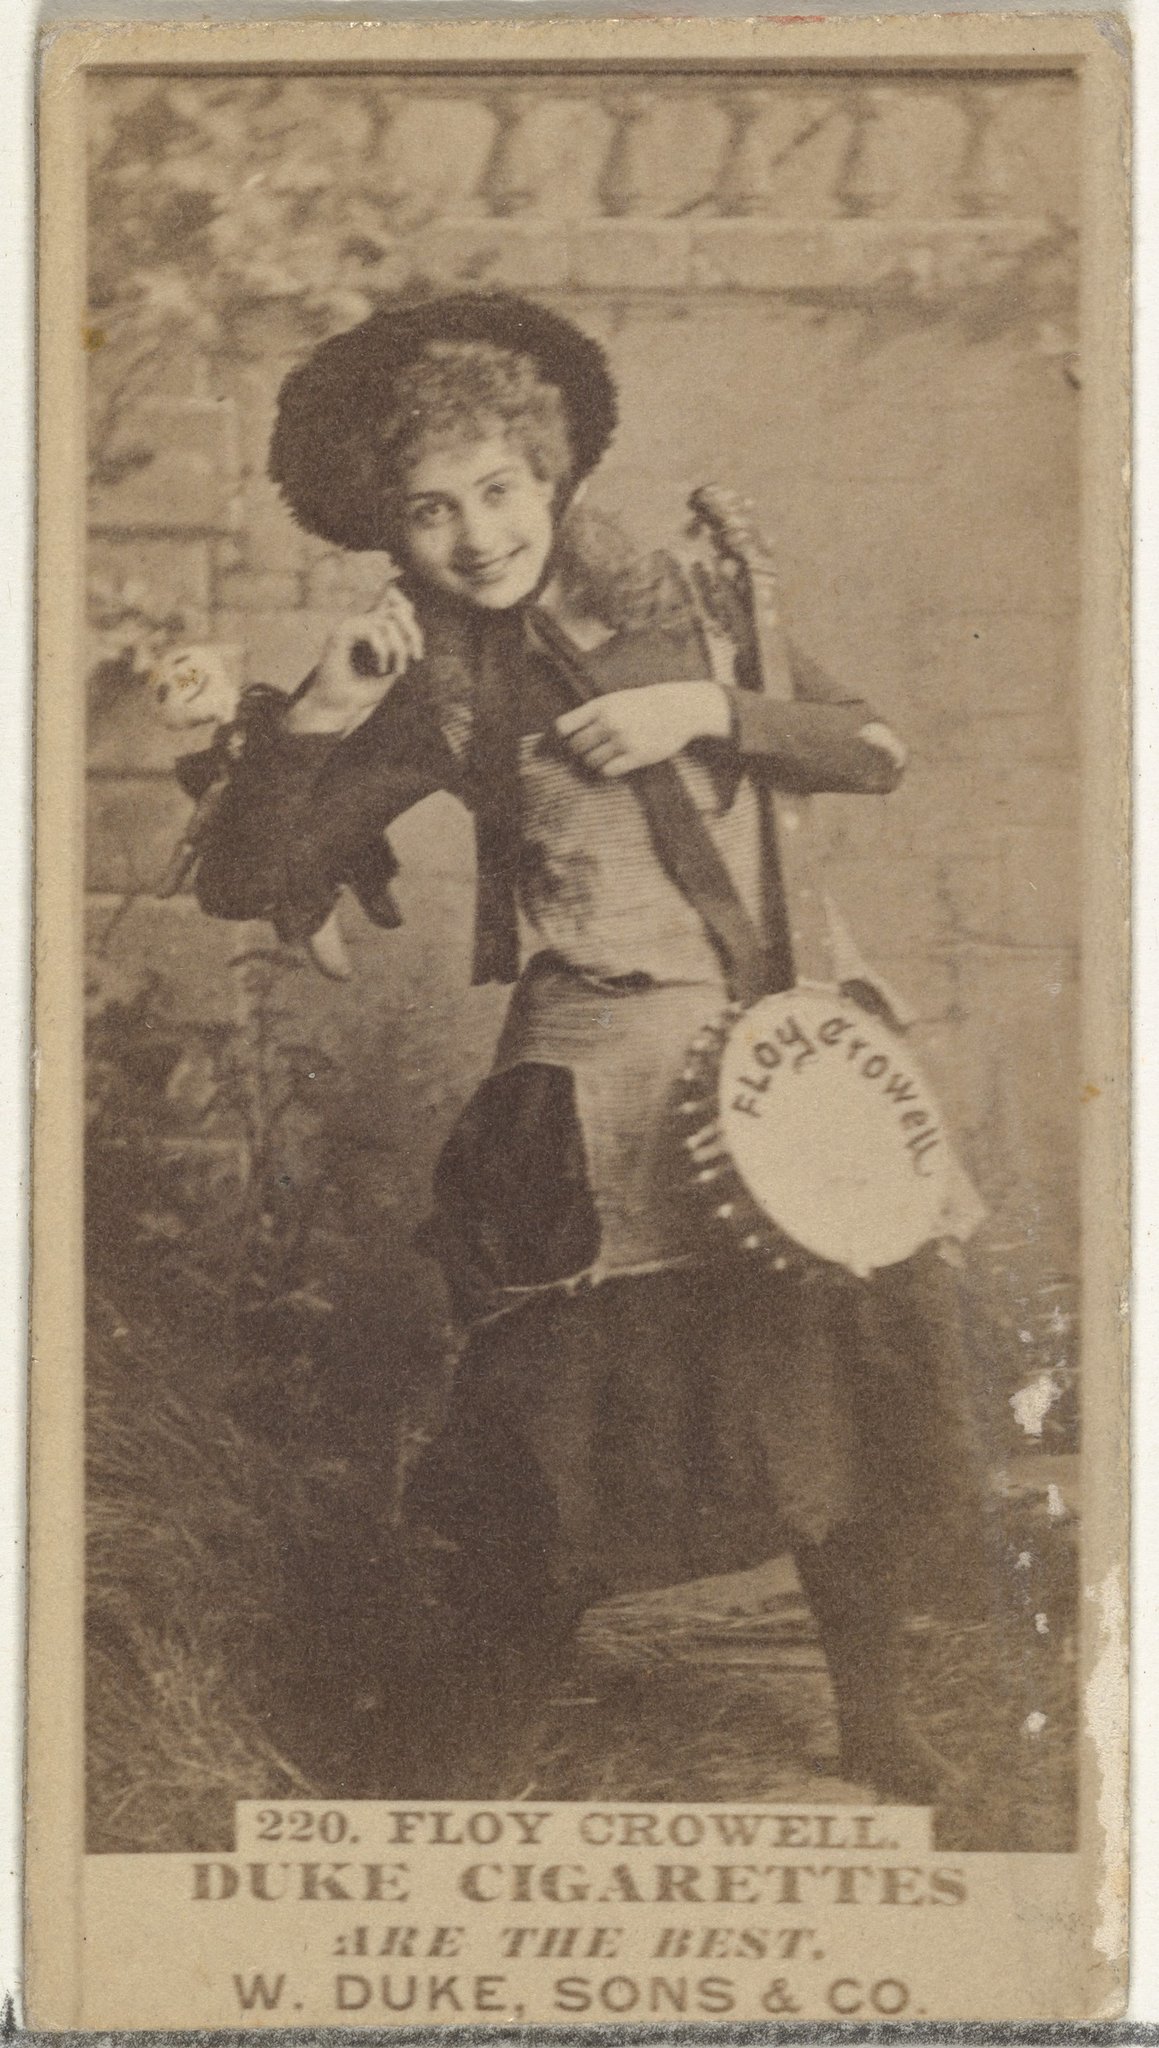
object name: photograph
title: Card Number 220, Floy Crowell, from the Actors and Actresses series (N145-7) issued by Duke Sons & Co. to promote Duke Cigarettes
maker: w. duke, sons & co.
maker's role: publisher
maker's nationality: american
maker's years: 1870-1920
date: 1880-1889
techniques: albumen silver print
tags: musical instruments,portraits,women,actresses